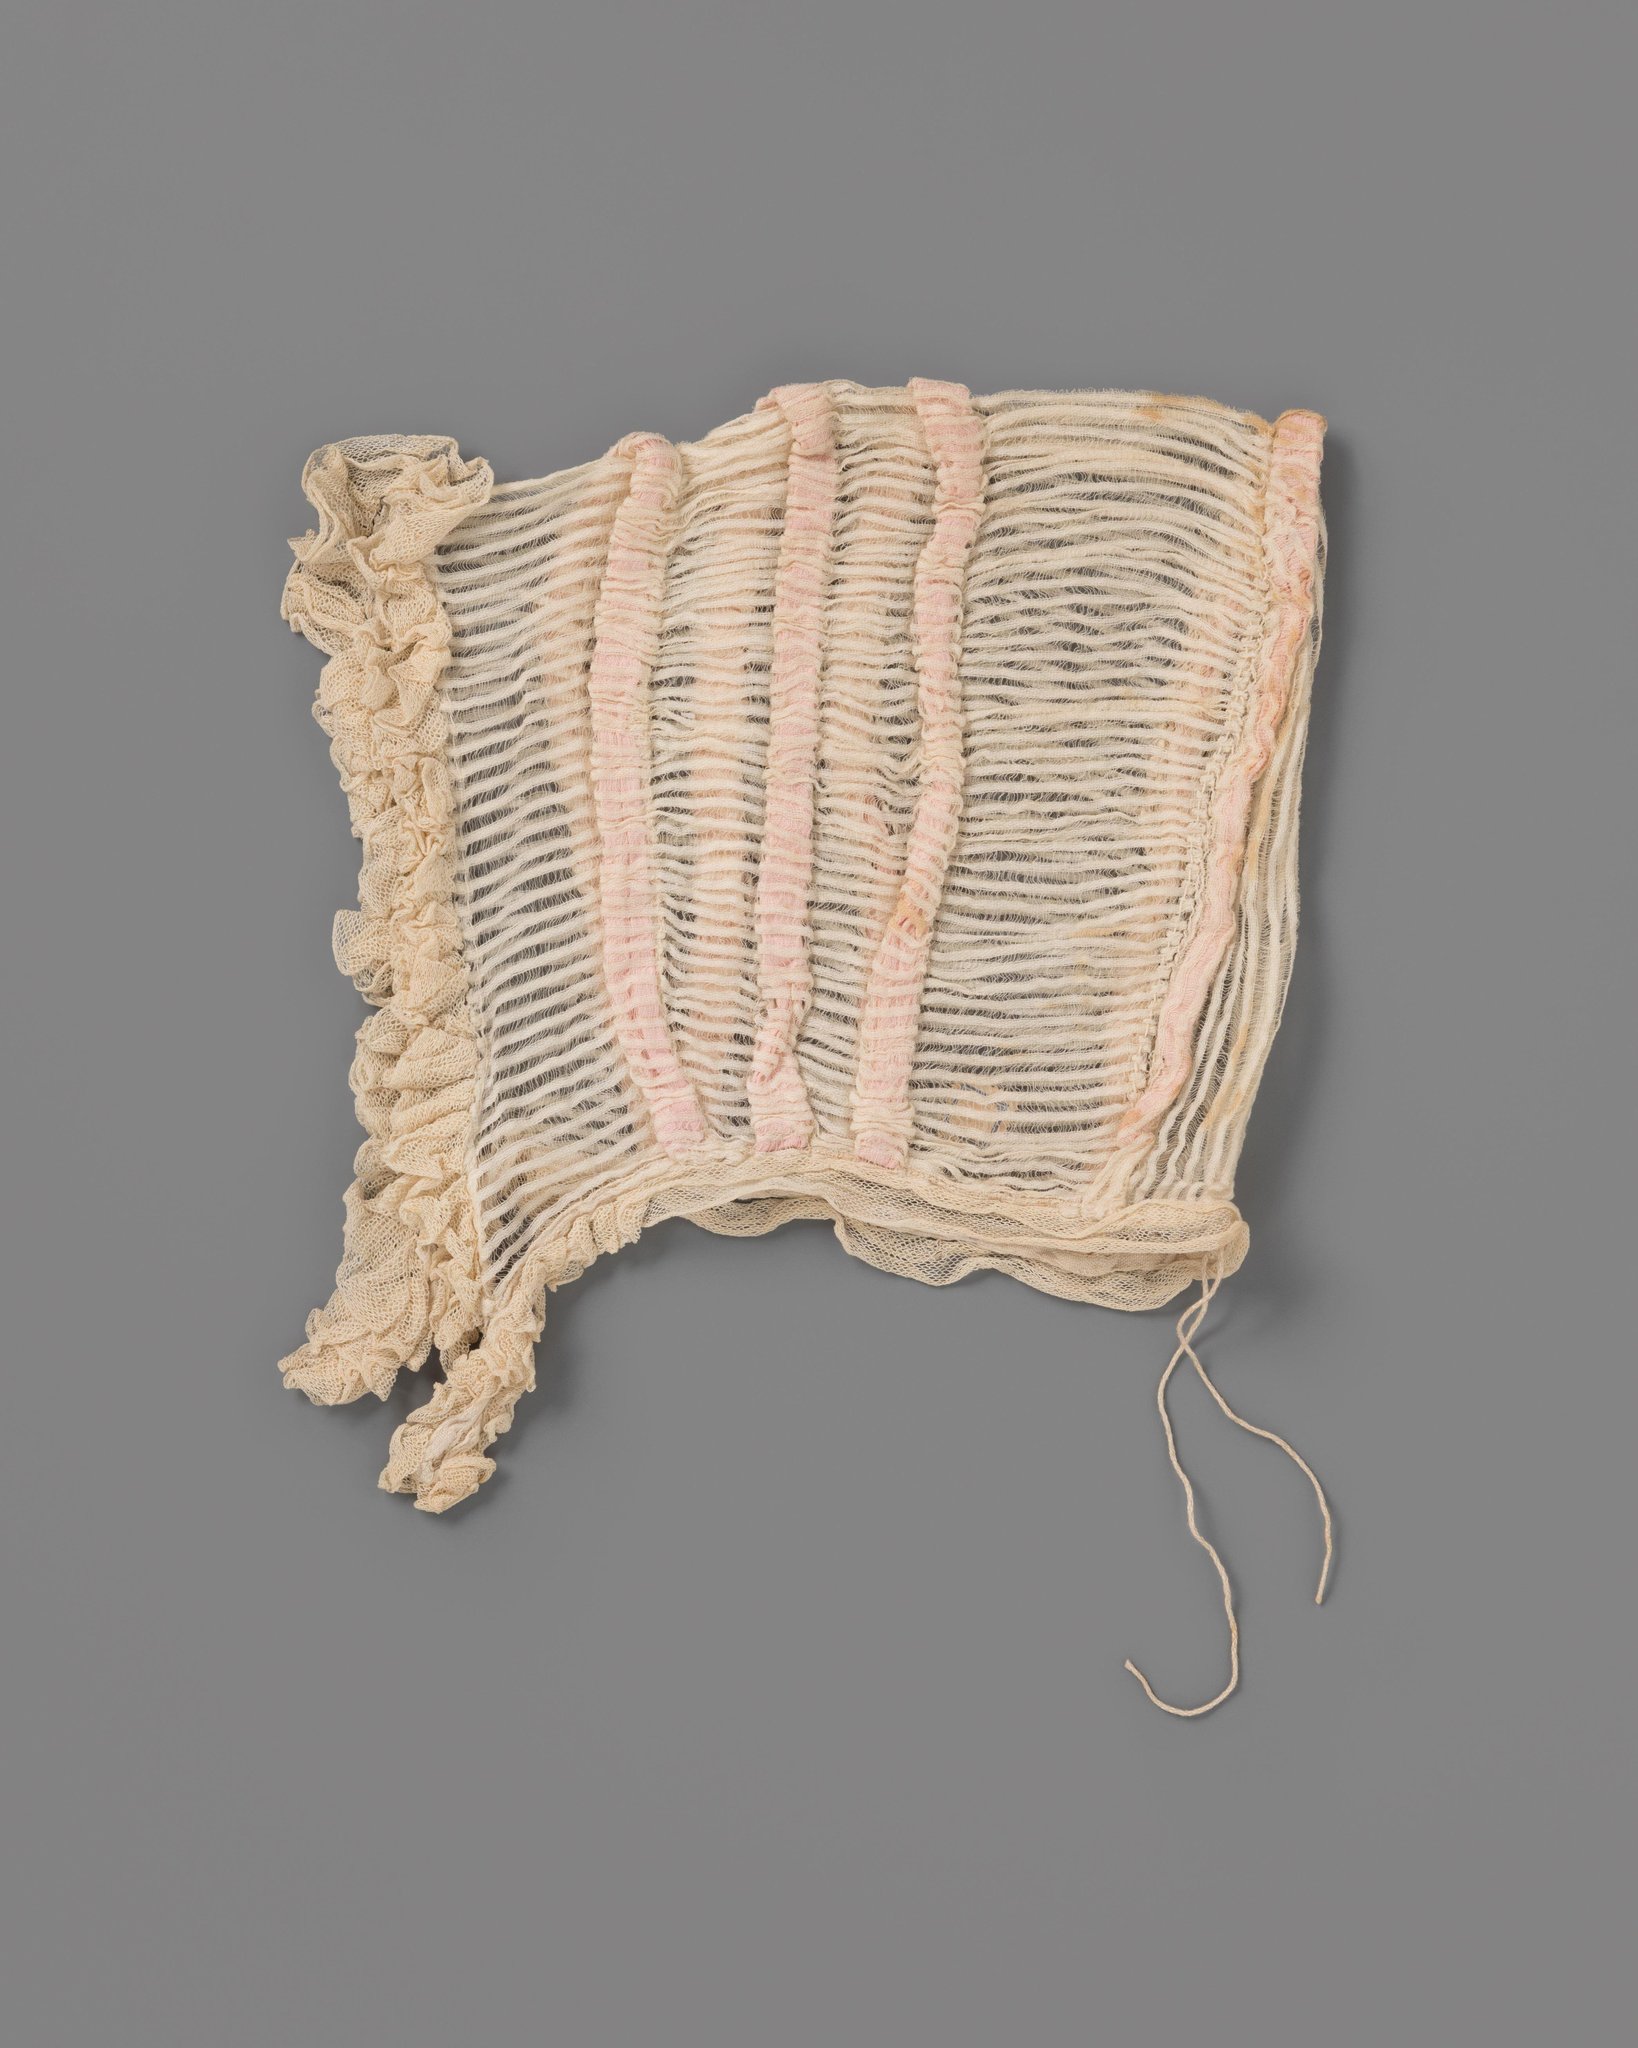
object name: cap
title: Muts van zijdegaas met streepdessin, met vier oprijgsels die met roze band zijn gevuld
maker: Anonymous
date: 1840-1860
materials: textile, silk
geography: western europe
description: Muts van zijdegaas met streepdessin. Op de muts vier oprijgsels opgevuld met roze band. De randen van de muts zijn afgezet met gerimpelde stroken tule.